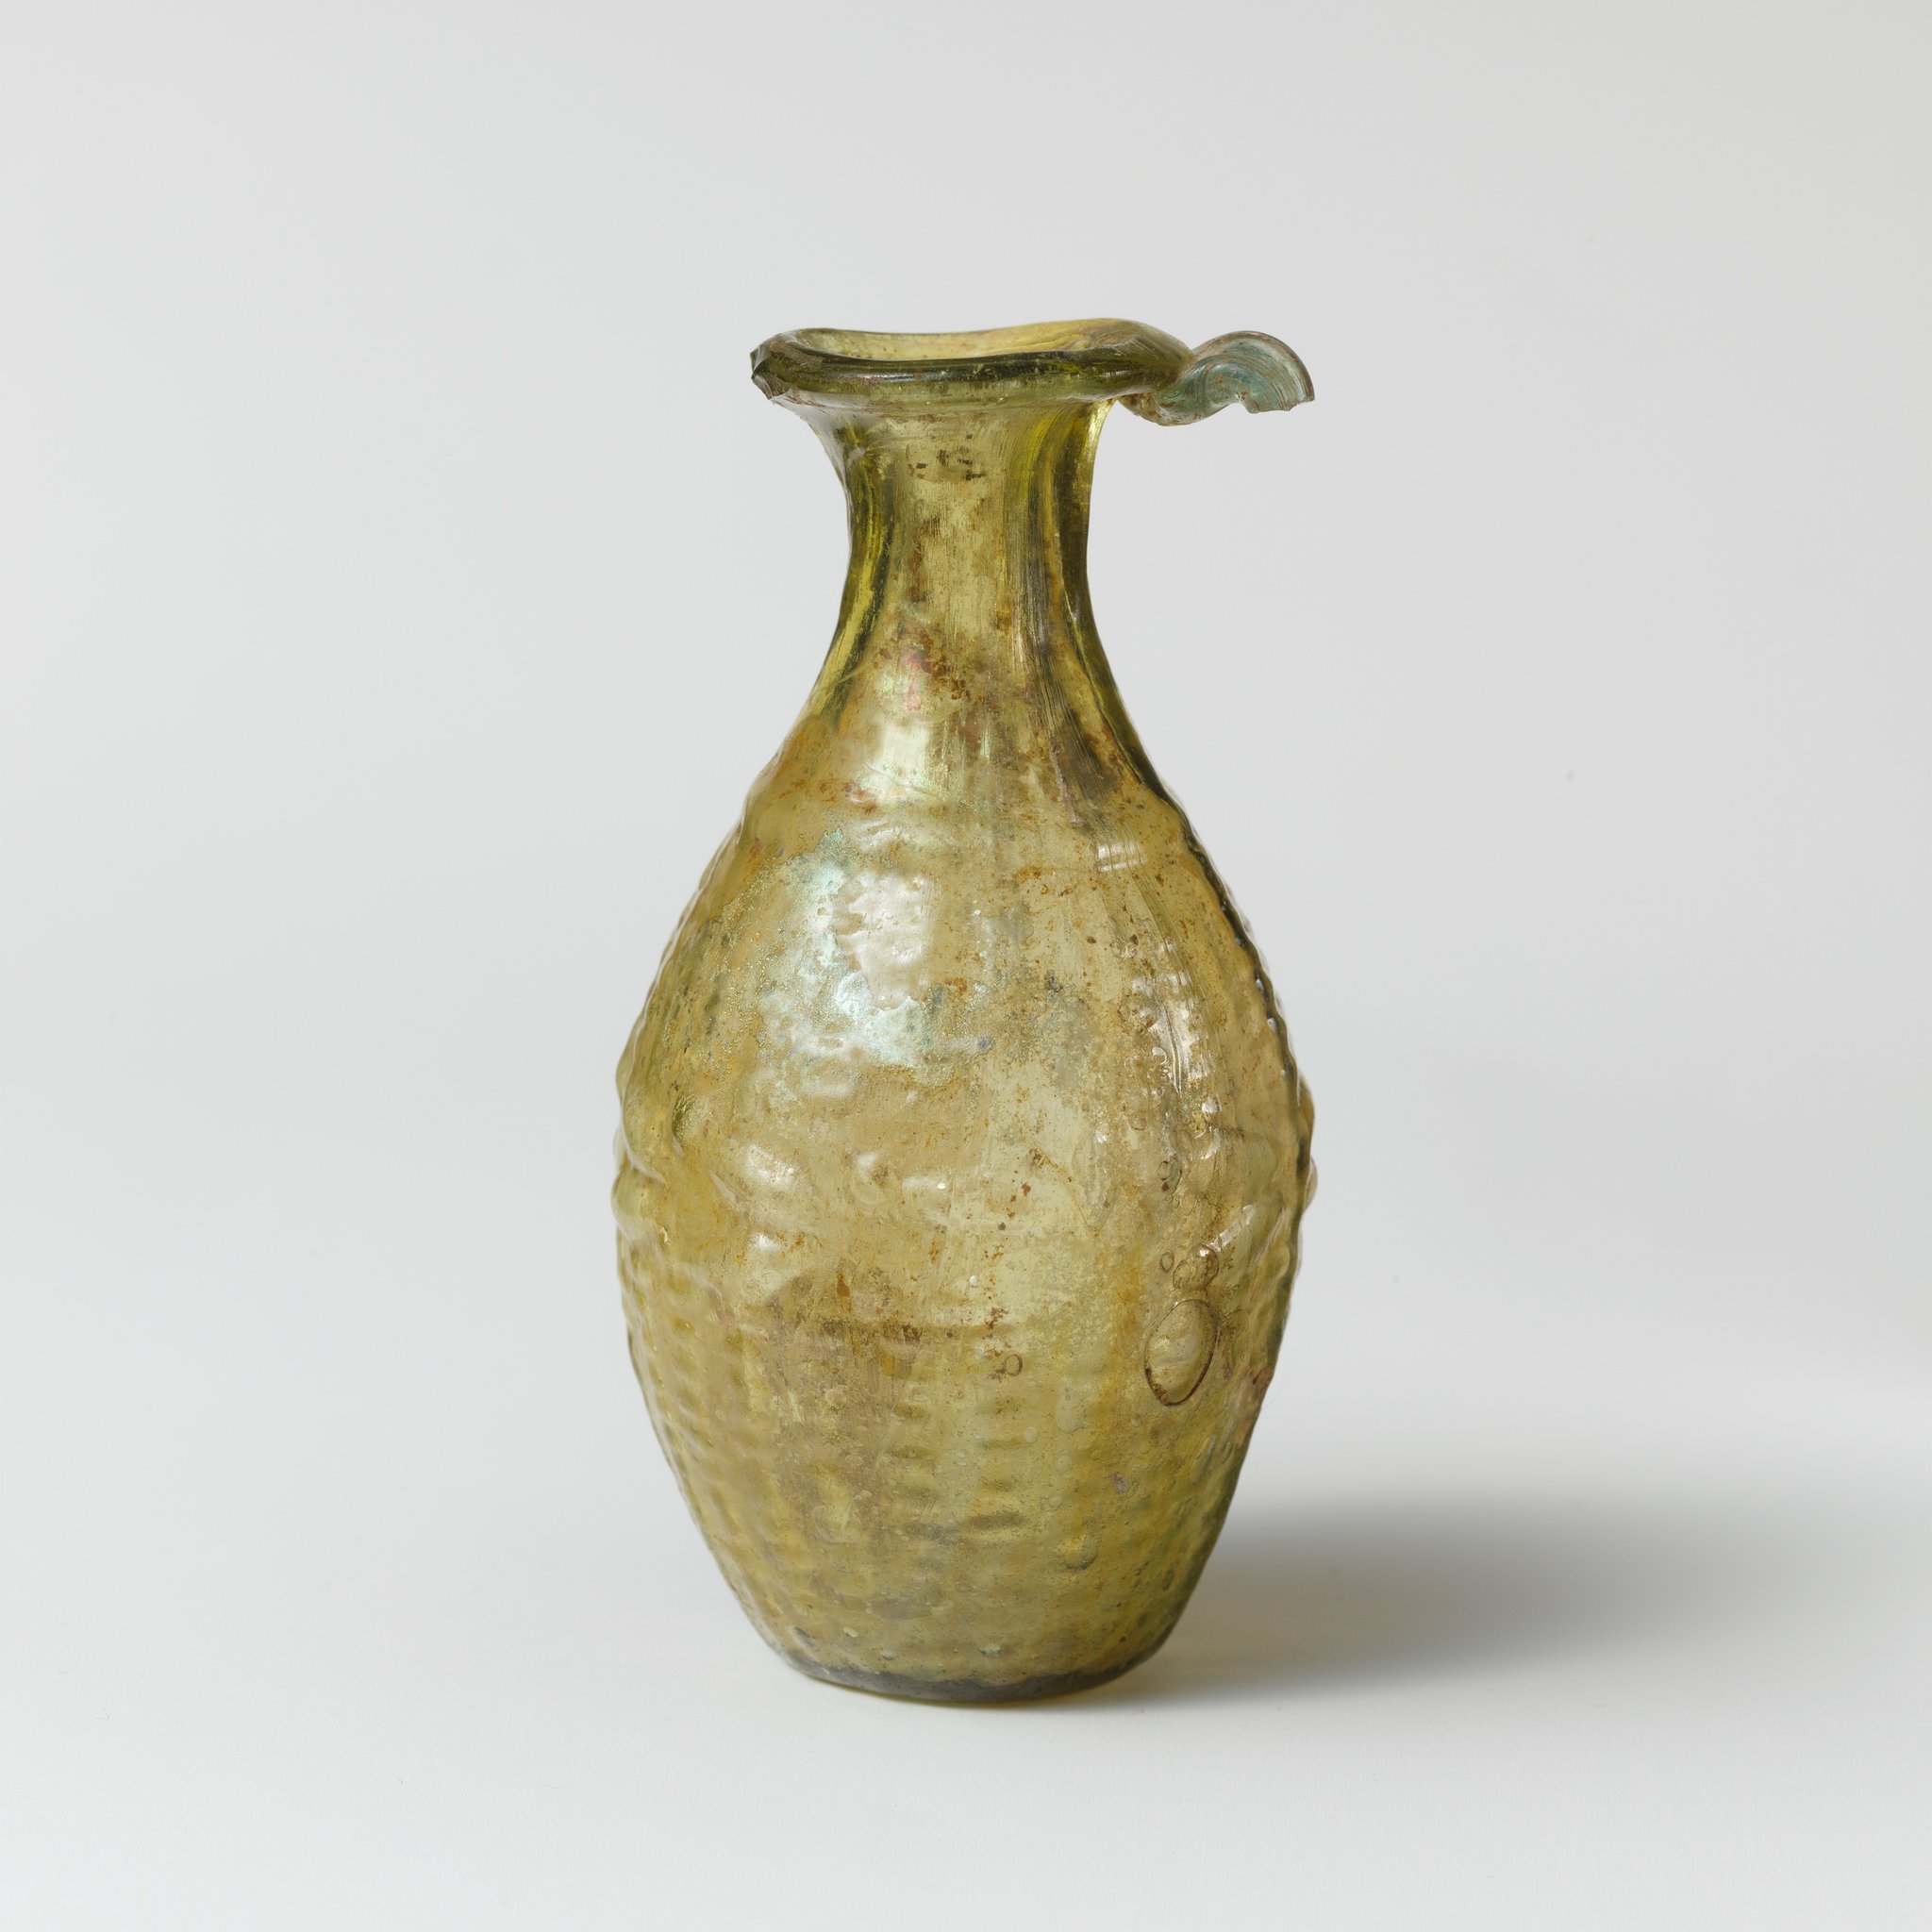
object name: amphoriskos, basket and wreath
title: Glass amphoriskos (flask)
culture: roman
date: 1-50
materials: glass